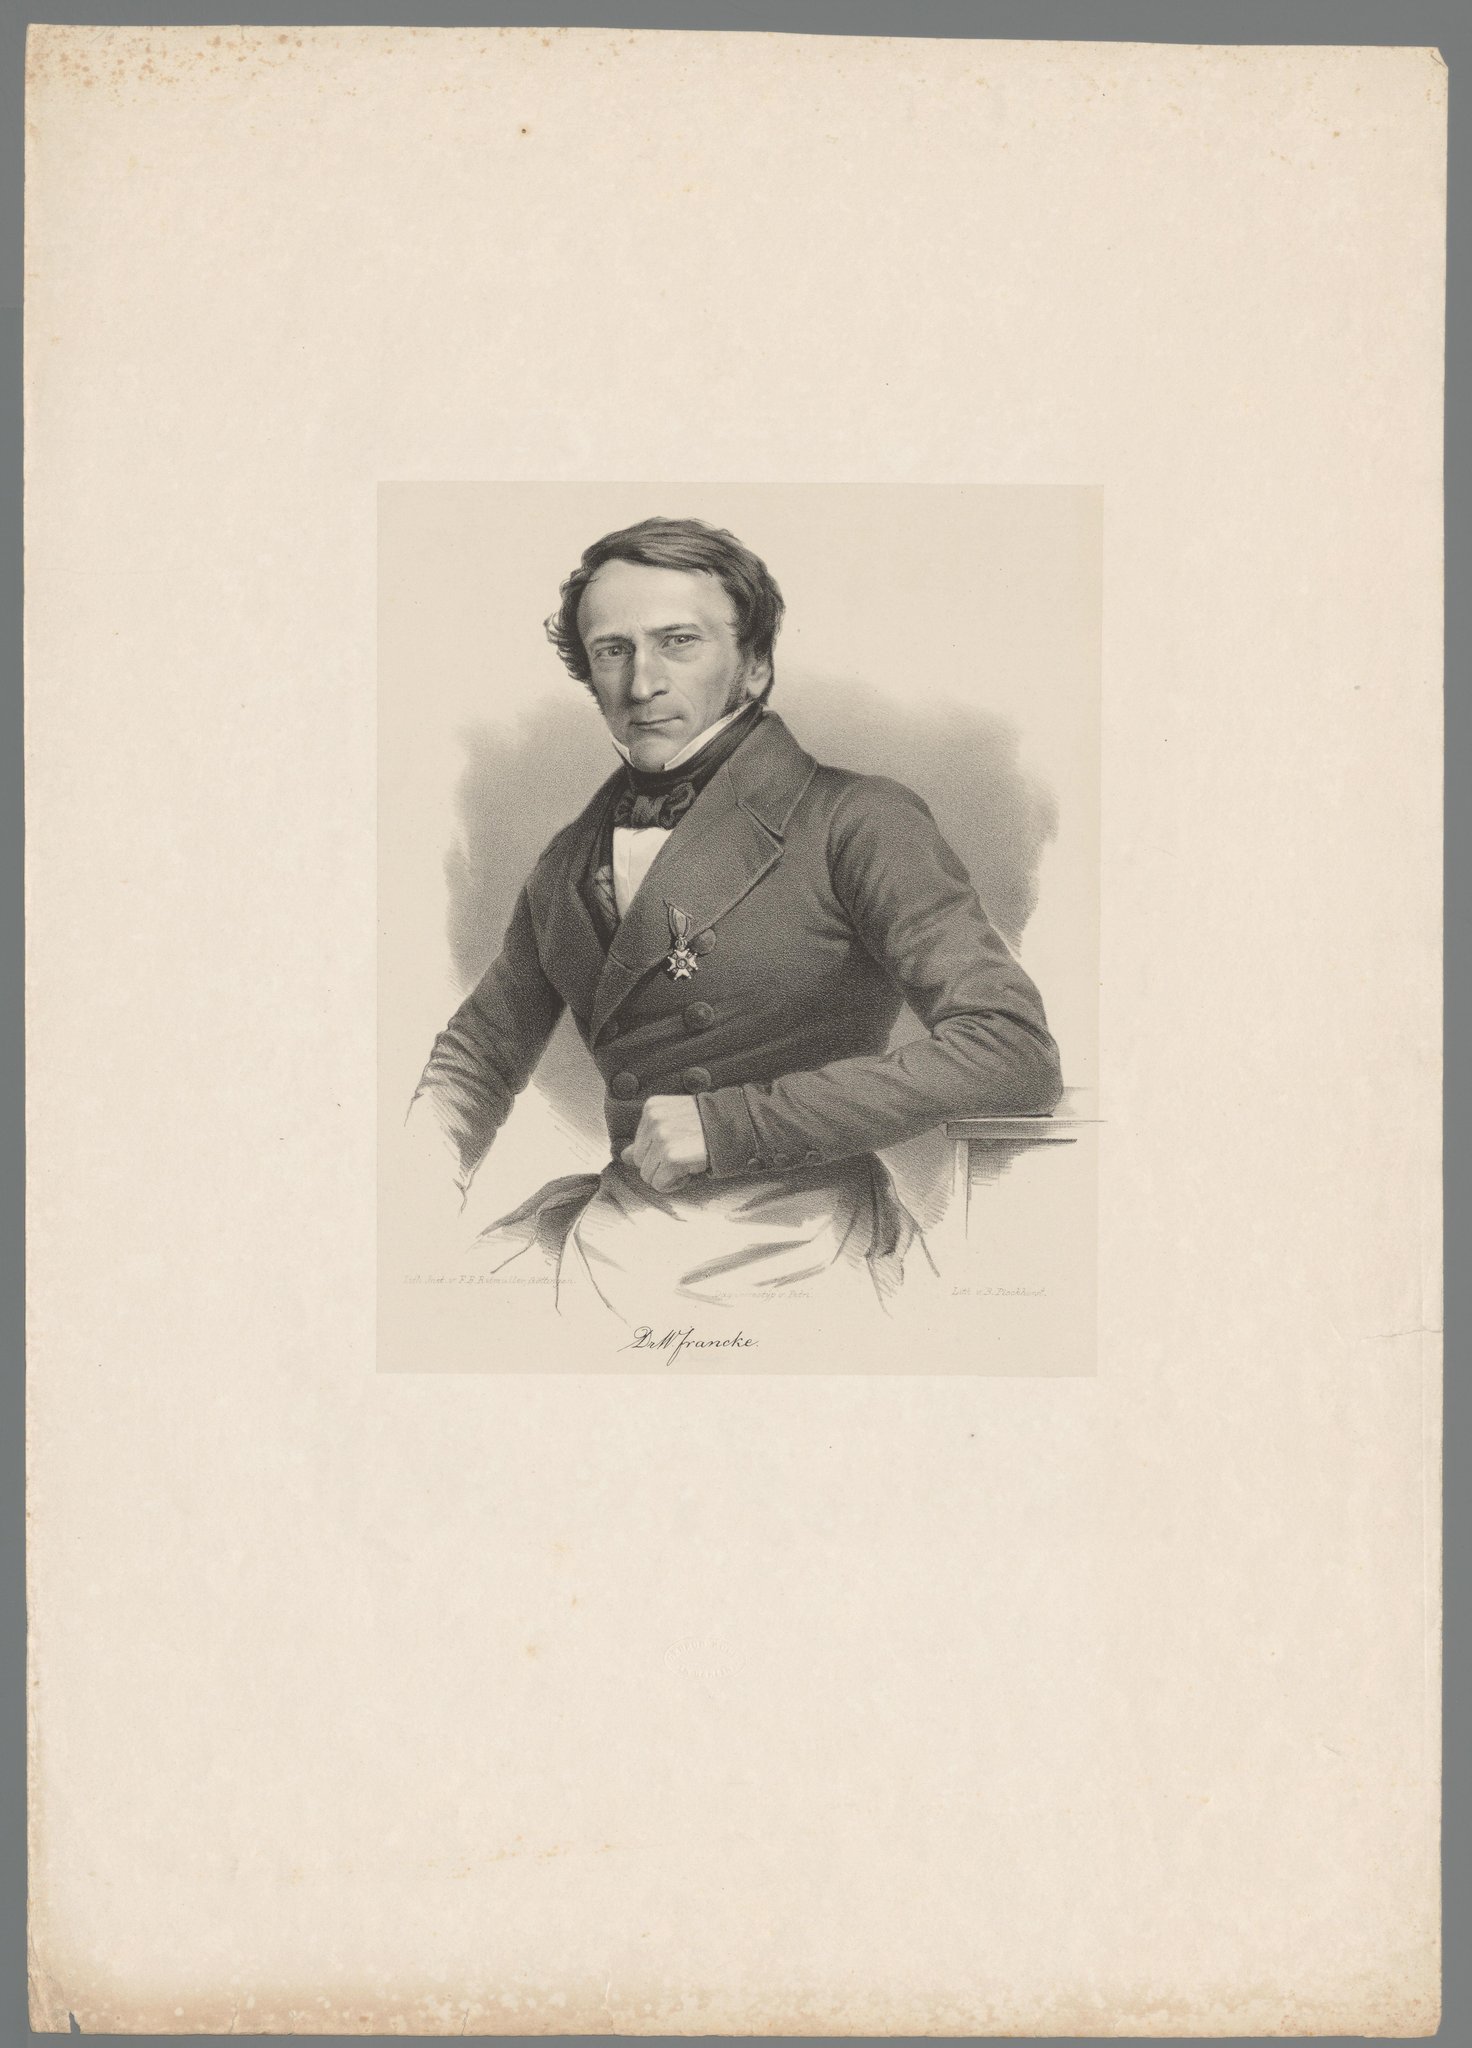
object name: print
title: Portret van een onbekende man, mogelijk August Wilhelm Francke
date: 1835-1875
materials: paper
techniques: lithograph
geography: berlin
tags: adult man, historical persons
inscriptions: check stamp: Lugt 2141c, collector's mark: Lugt 2228